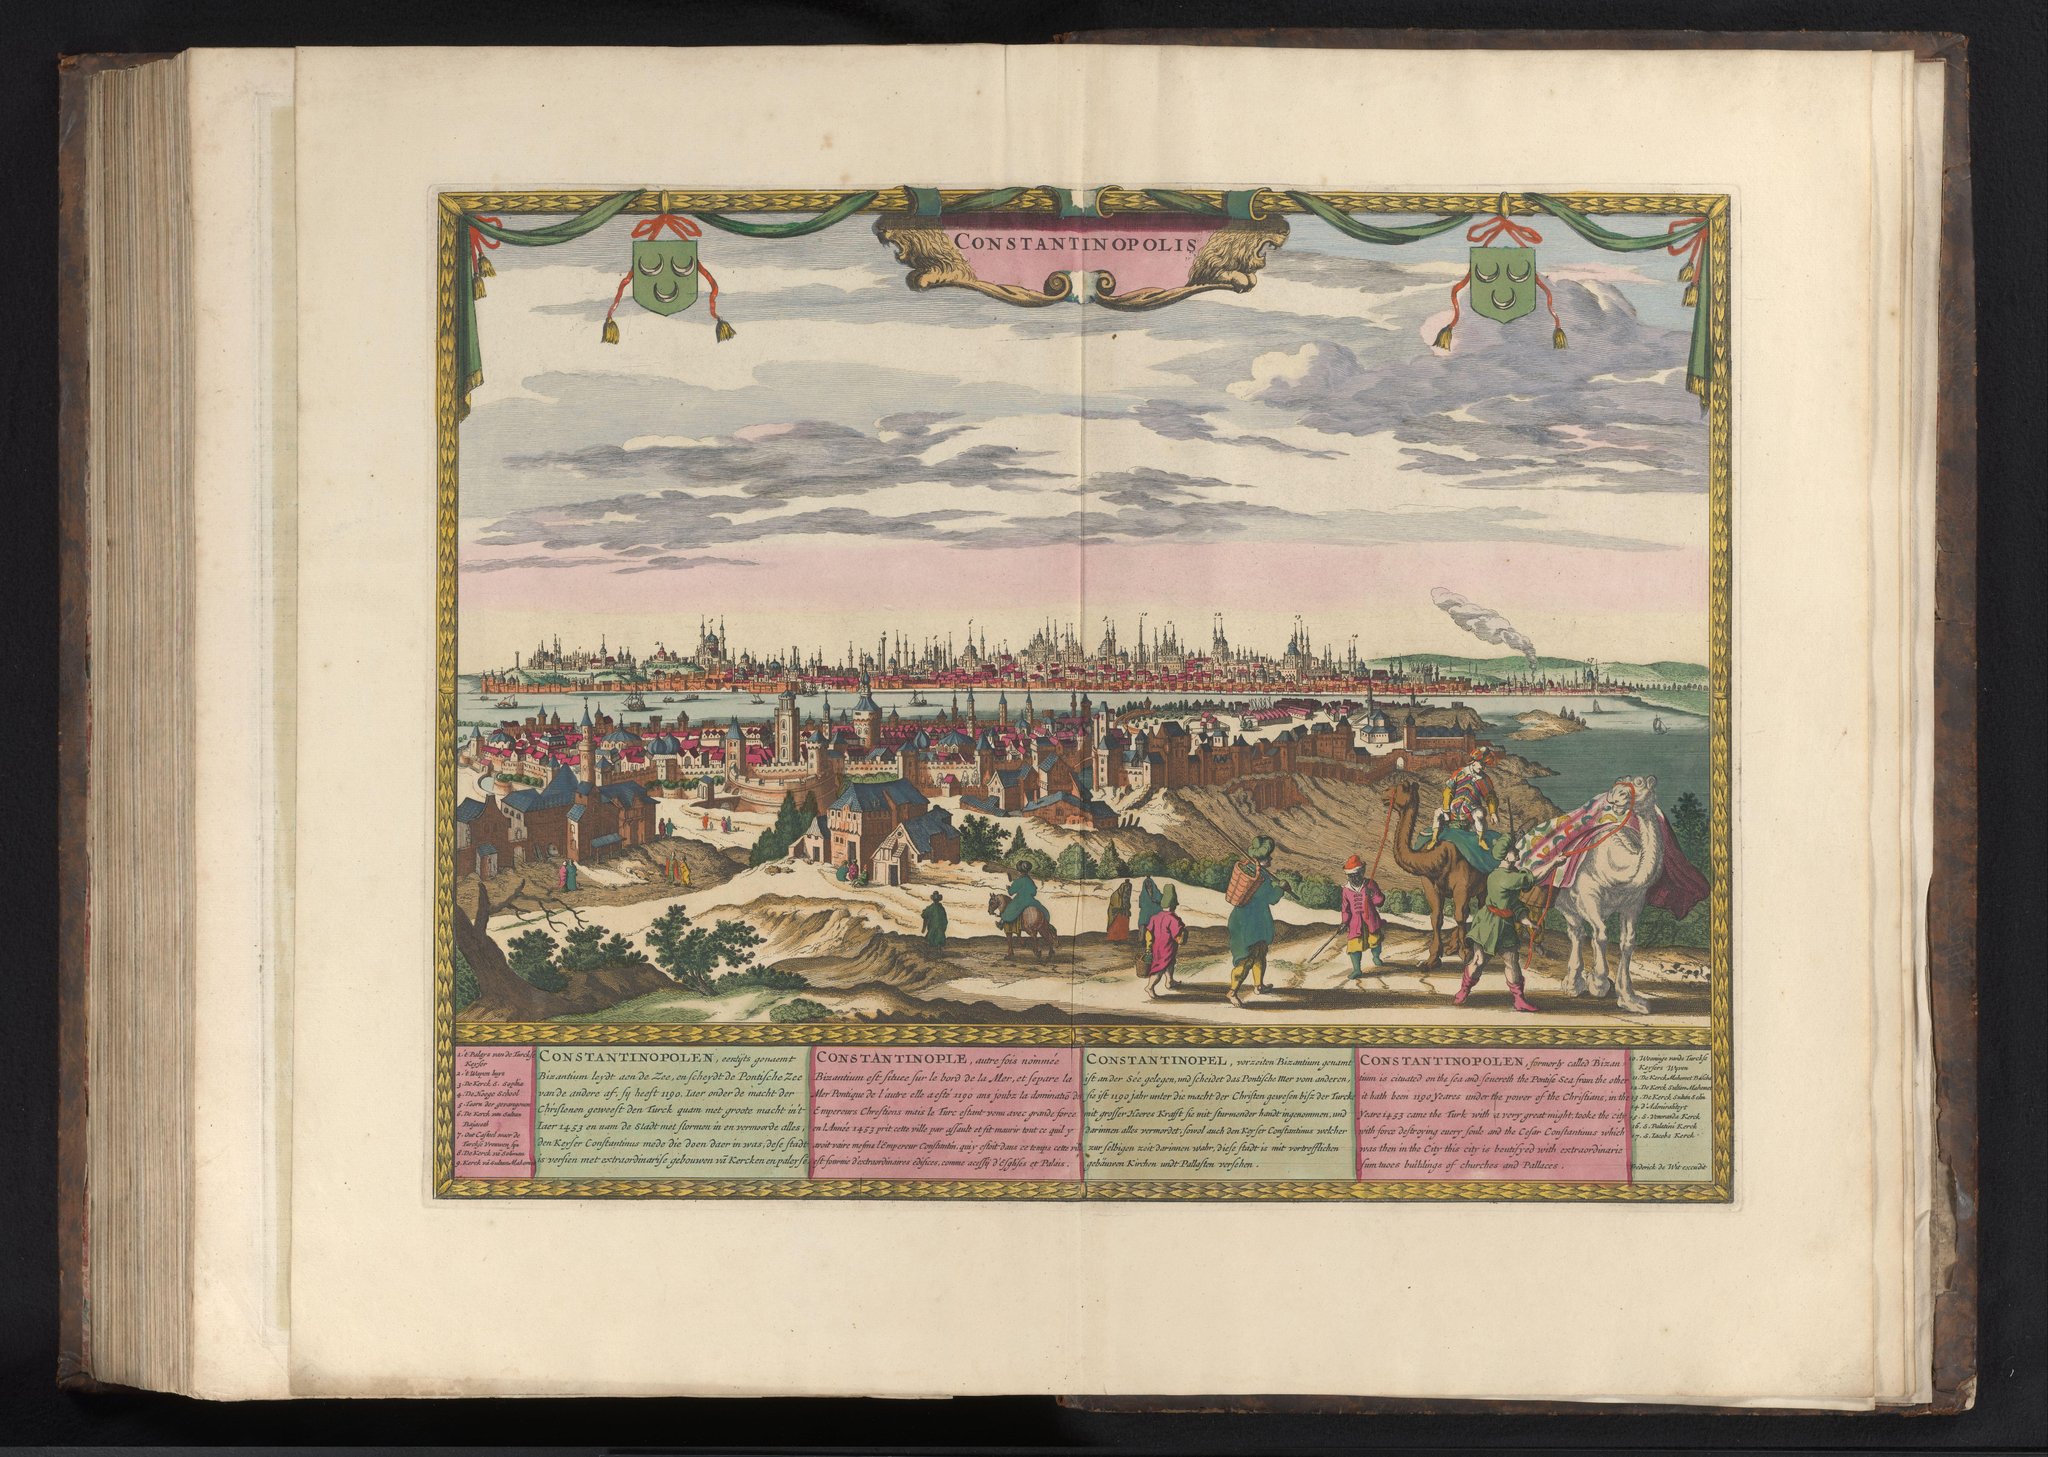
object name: album leaf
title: Gezicht op Constantinopel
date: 1639-1706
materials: paper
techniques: colour, etching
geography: amsterdam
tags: hoofed animals: camel, city-view, and landscape with man-made constructions, 'en route', traveller under way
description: Gezicht op Constantinopel. Op de voorgrond rechts reizigers met kamelen. Midden boven een cartouche met de titel. Onderschift in het Nederlands, Frans, Duits en Engels. Prent maakt deel uit van een album.